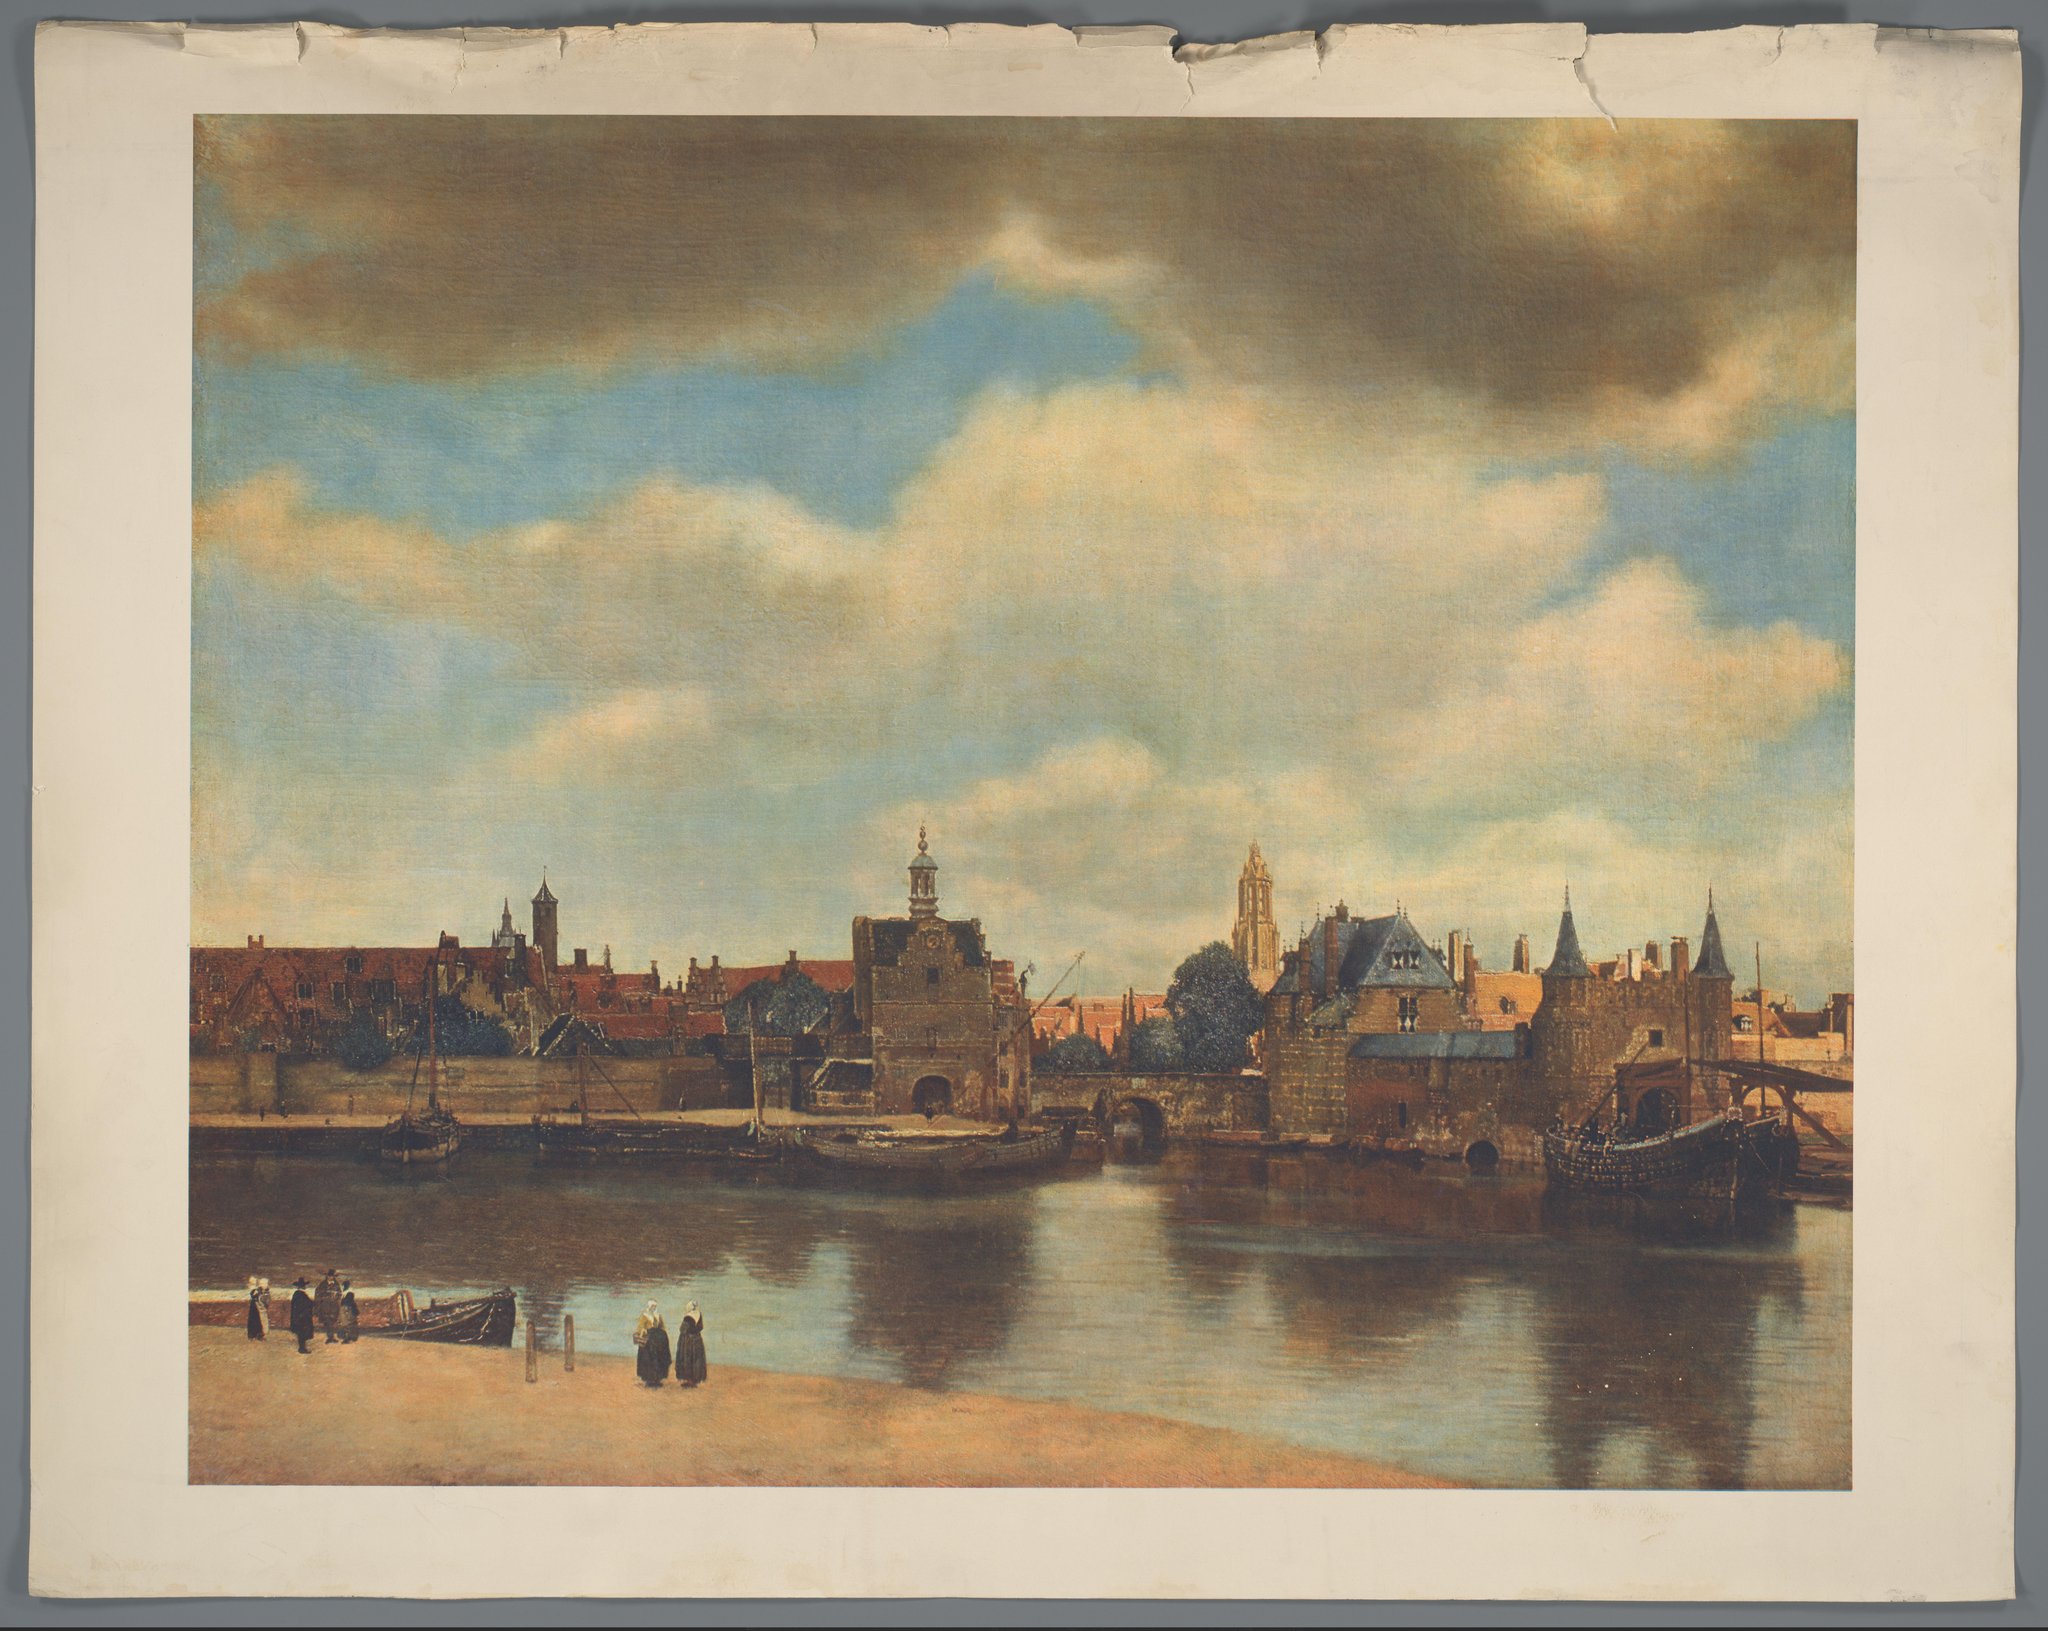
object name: photomechanical print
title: Fotoreproductie van Gezicht op Delft door Johannes Vermeer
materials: cardboard, paper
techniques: rotogravure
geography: berlin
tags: city-view, and landscape with man-made constructions, picture, painting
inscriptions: inscription: ‘'27 : 38’